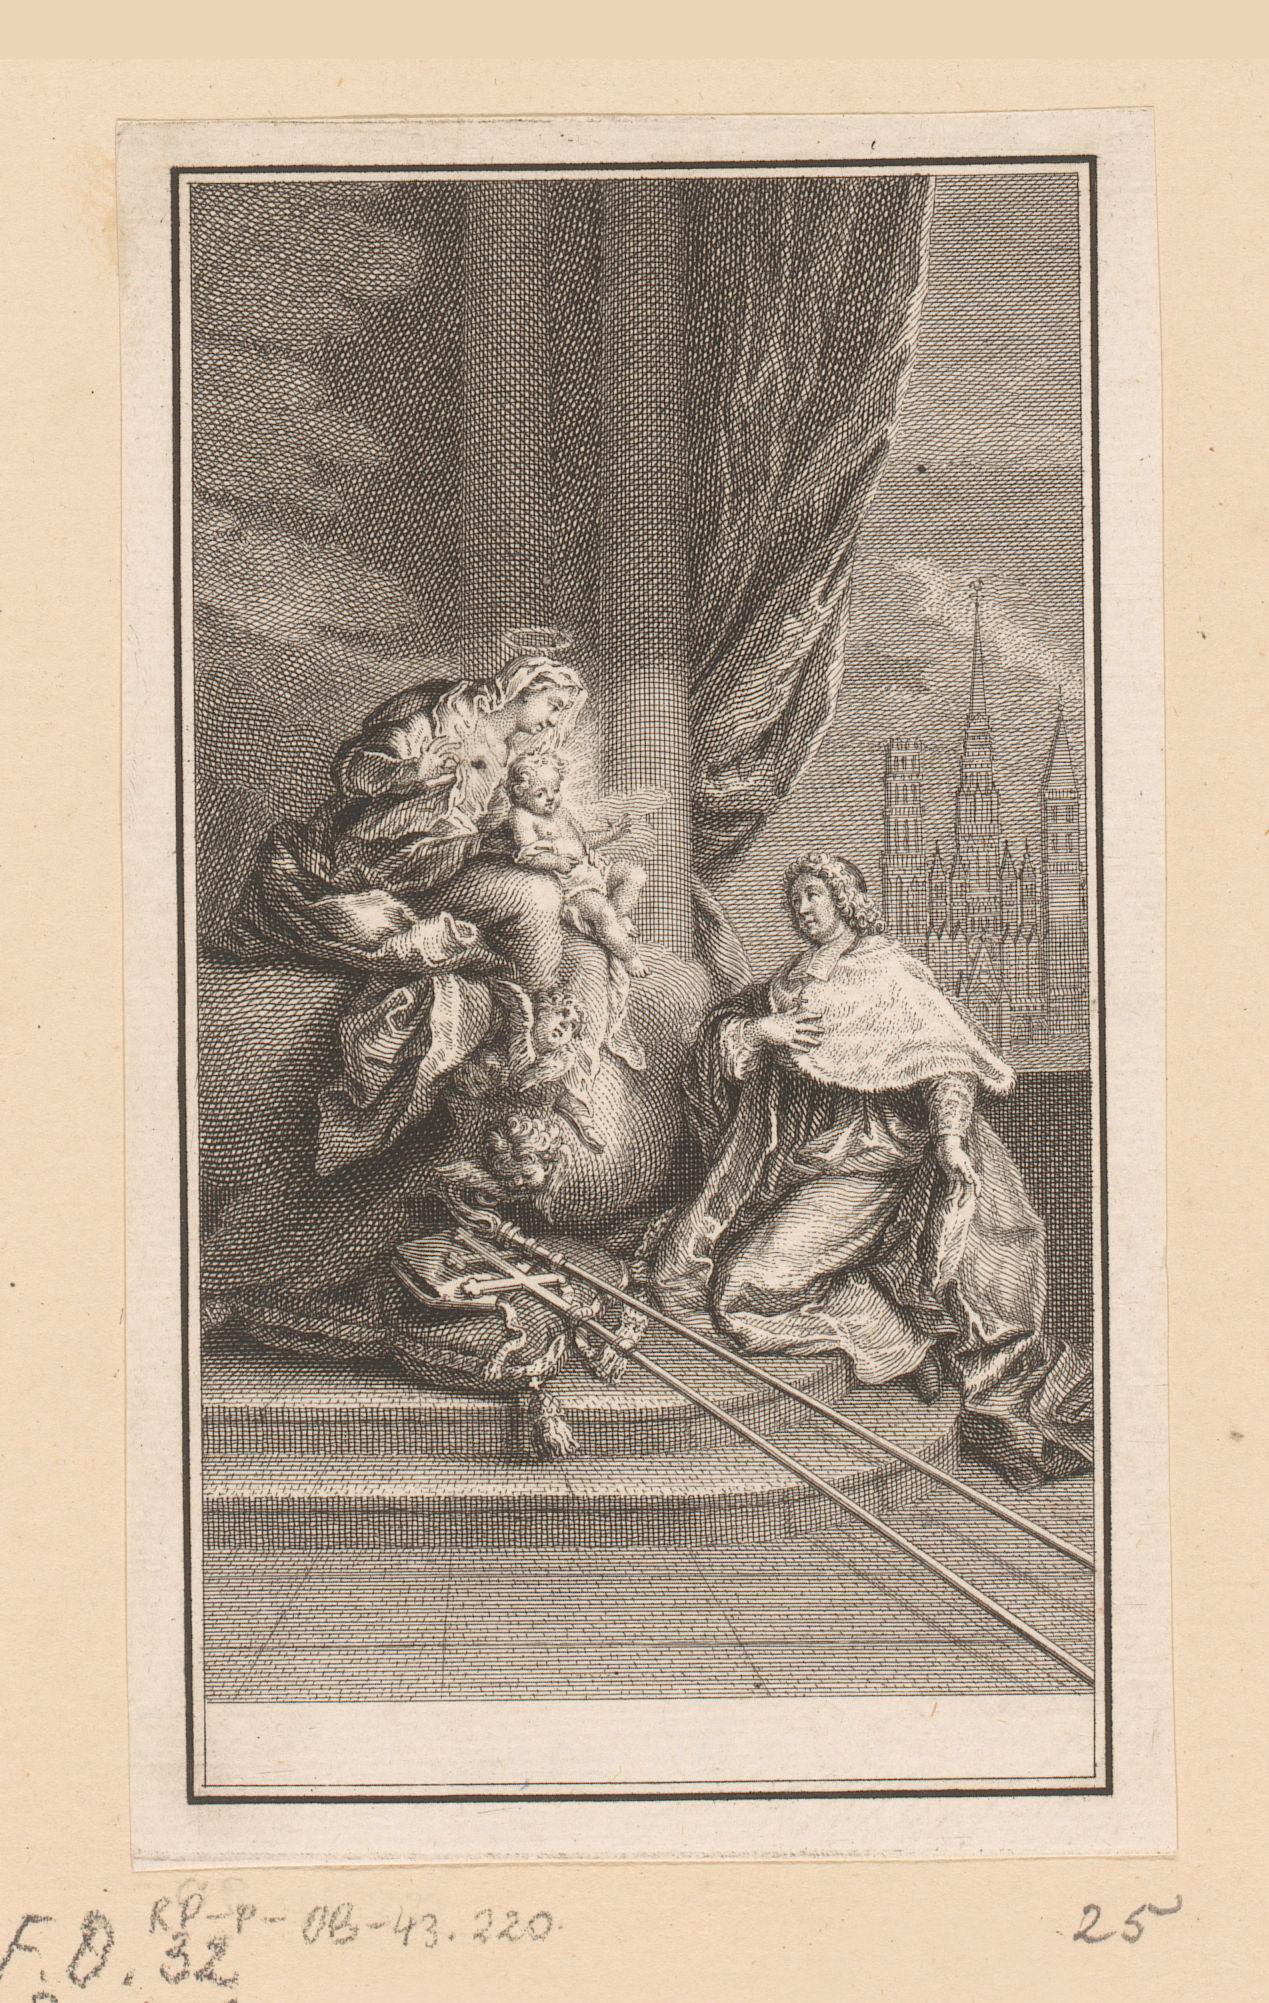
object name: print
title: Louis de La Vergne de Tressan in aanbidding voor Maria en Christuskind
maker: pierre imbert drevet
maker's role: print maker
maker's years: 1697-1739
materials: paper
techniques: engraving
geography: france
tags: madonna: i.e. mary with the christ-child, historical persons, church (exterior)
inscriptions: collector's mark: Lugt 240